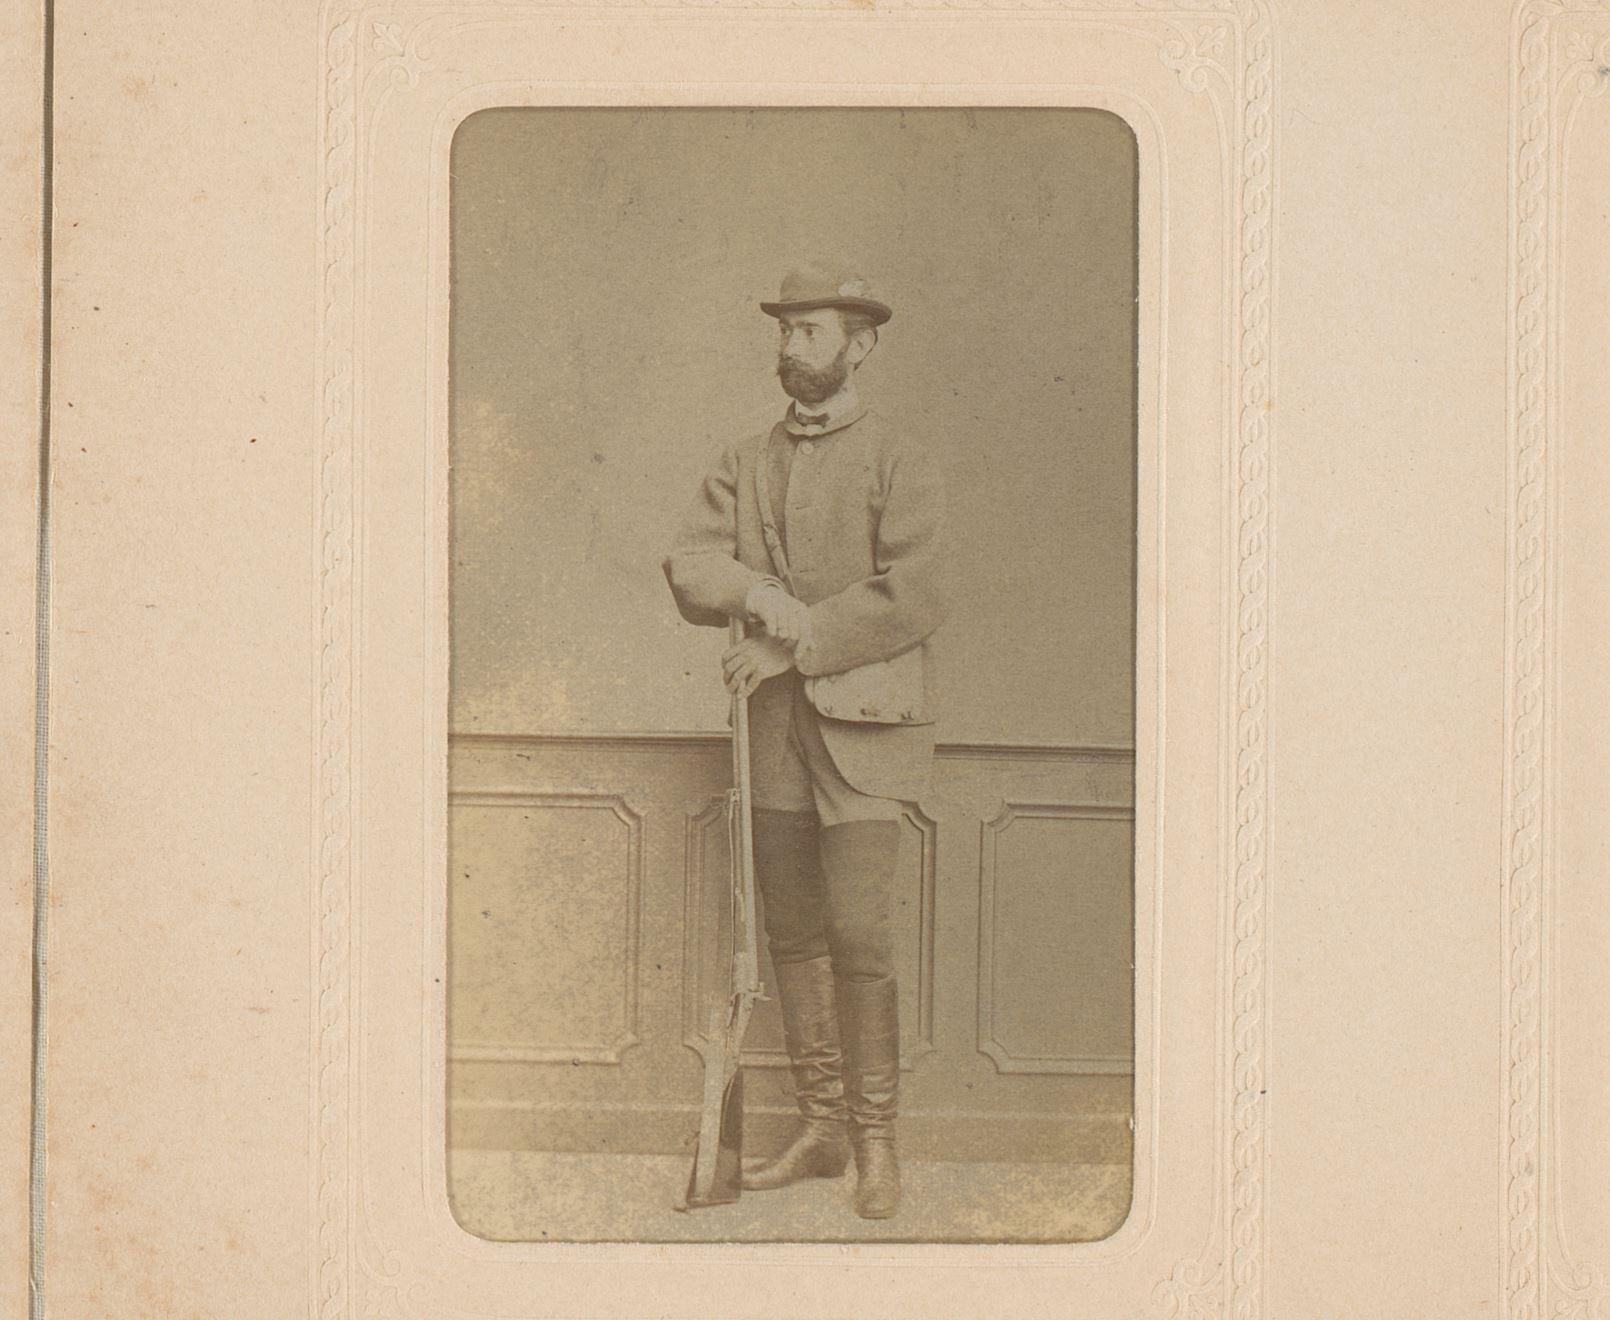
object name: photograph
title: Portret van een staande man met hoed en tas met jachtgeweer in de hand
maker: hynek fiedler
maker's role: painter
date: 1860-1900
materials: cardboard, photographic support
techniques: albumen print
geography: prague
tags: hunter, historical persons, firearms: rifle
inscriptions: name: ‘Bla[.]a z[.]evah/ [...]’, inscription: ‘H. Fiedler/ Fotograf i malir/ v PRAZE/ Václavské námesti c. 783-II./ Matrice se zachová.’, annotation: ‘AK’